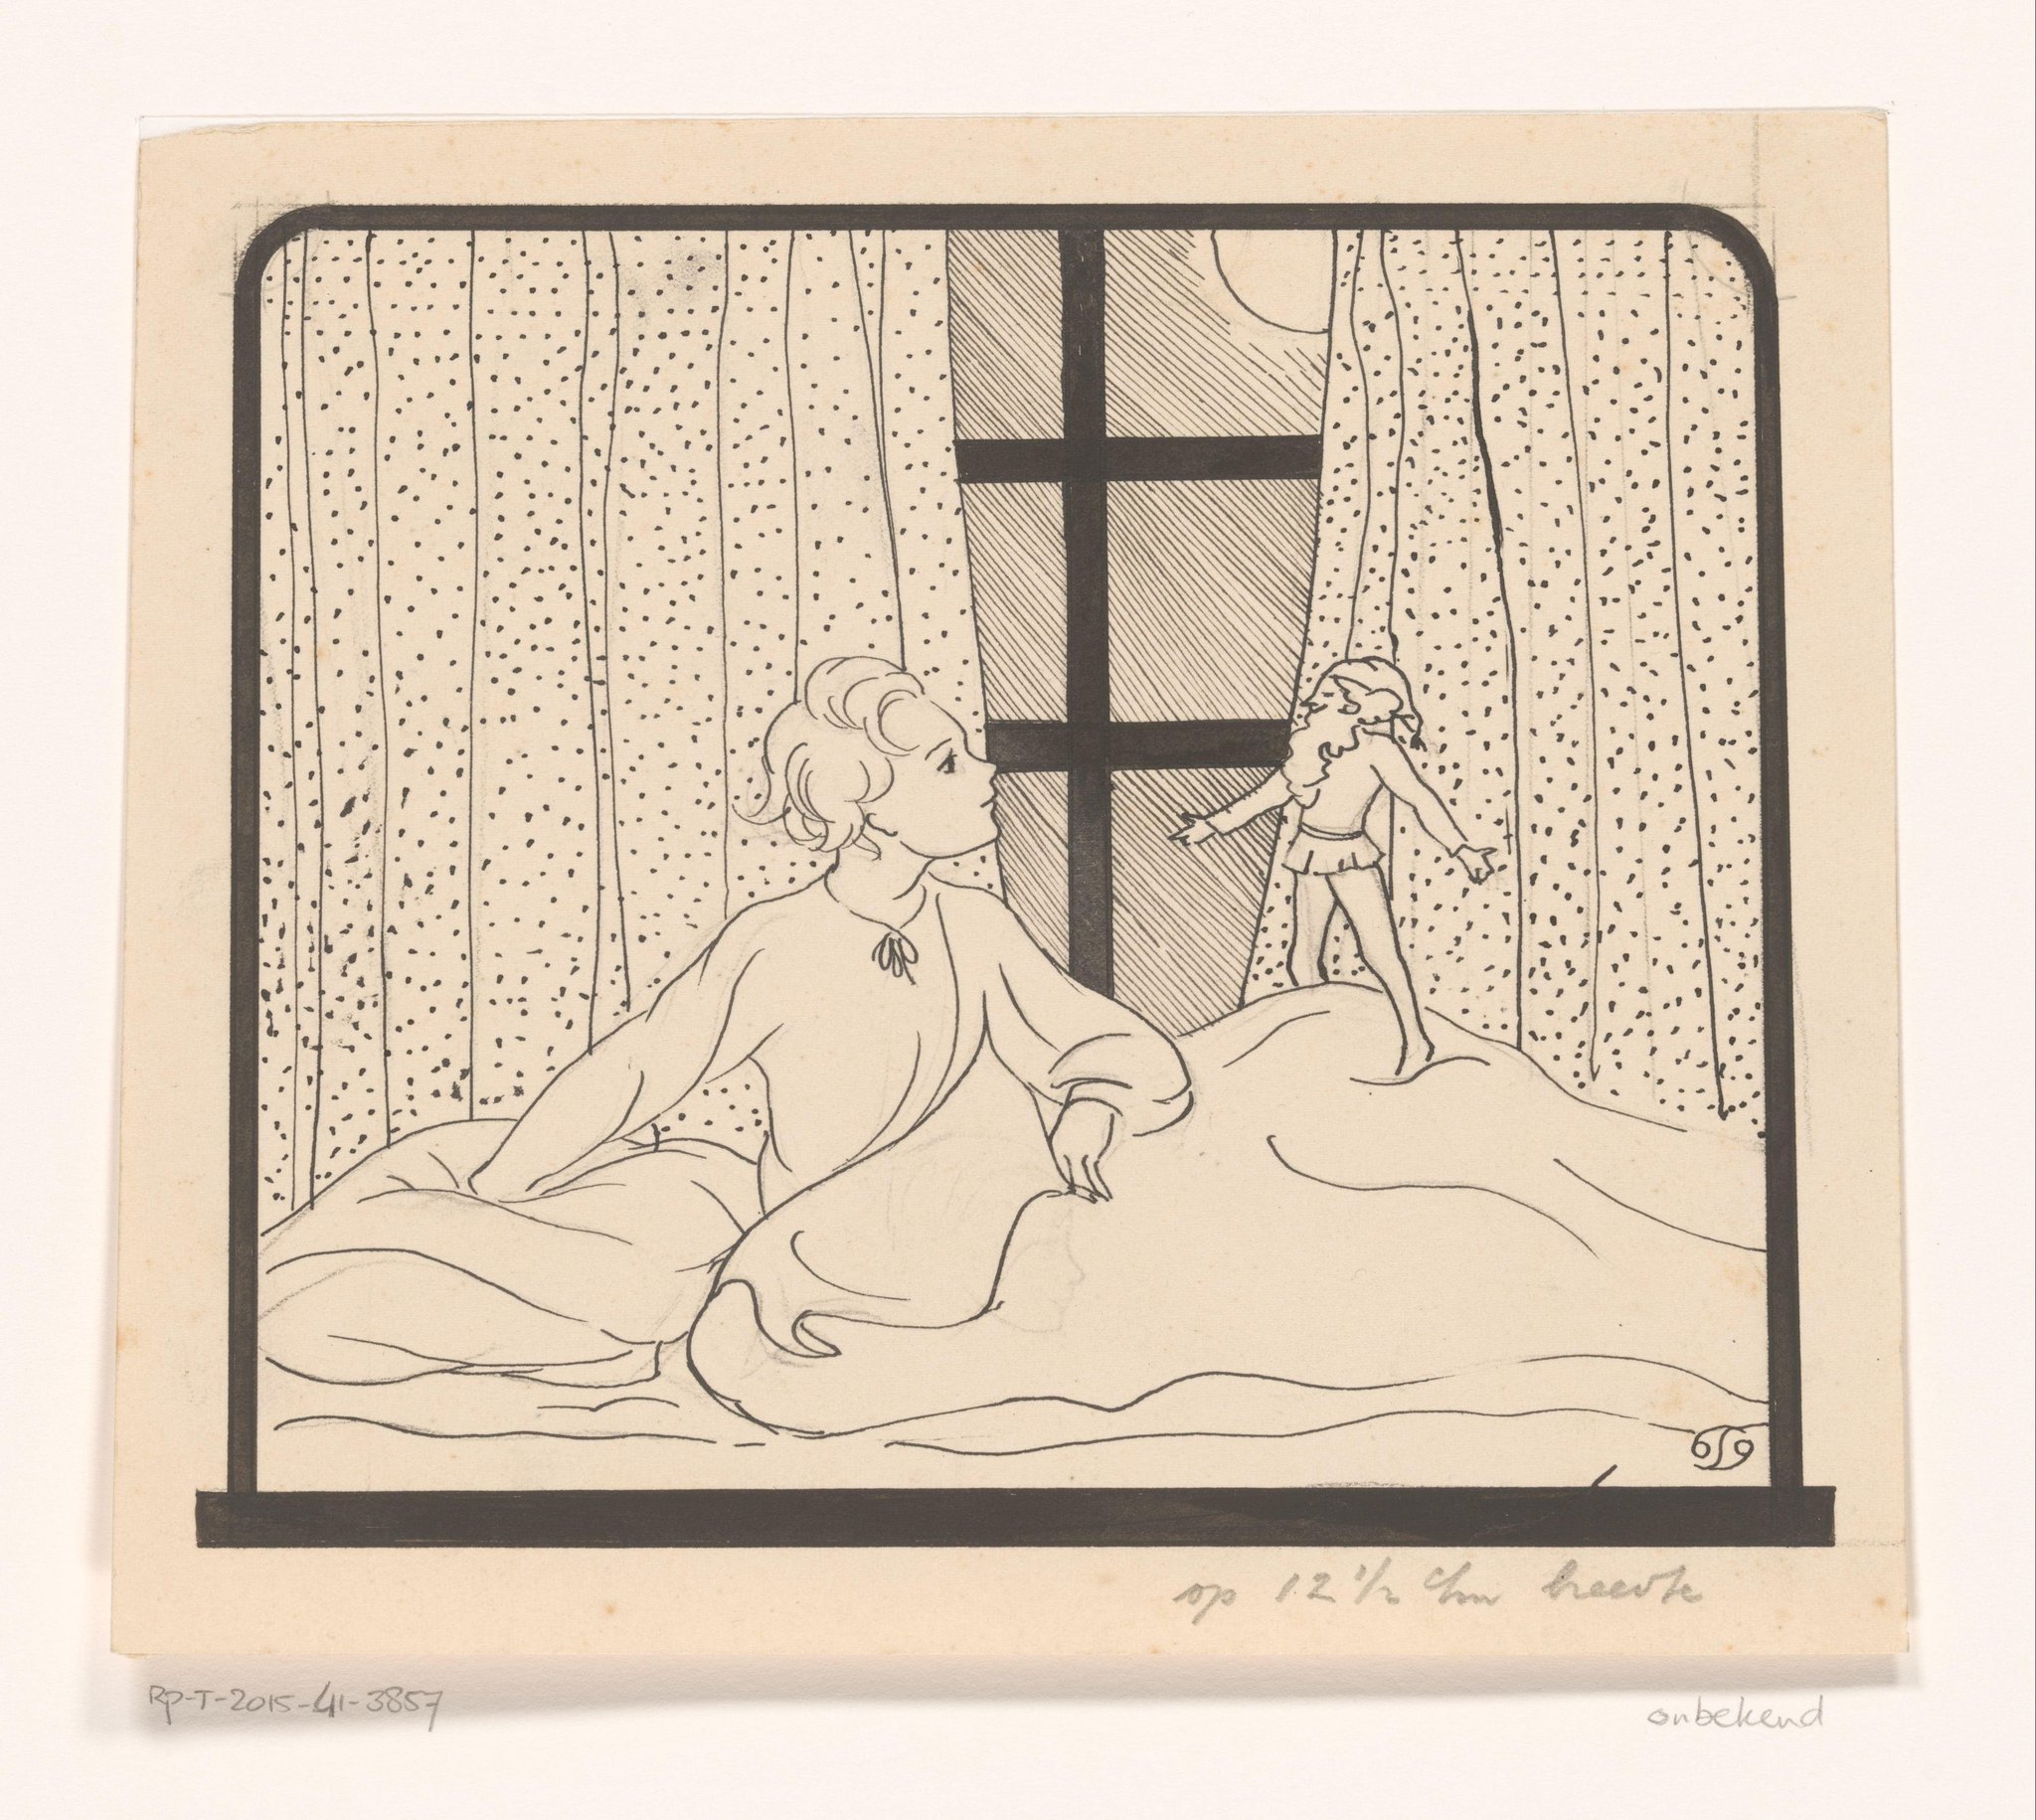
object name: boekillustratie ontwerp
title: Meisje luistert naar een kabouter die op haar bed staat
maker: Anonymous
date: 1890-1940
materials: ink, paper, pencil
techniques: brush, pen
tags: spirit of the earth, gnome, troll, bed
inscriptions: monogram, annotation: ‘- Als je maar wist,/ wat ik weet.’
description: Een meisje zit rechtop in een bed bij een raam. De gordijnen zijn deels open waardoor de maan door het raam te zien is. Op het bed staat een kabouter.